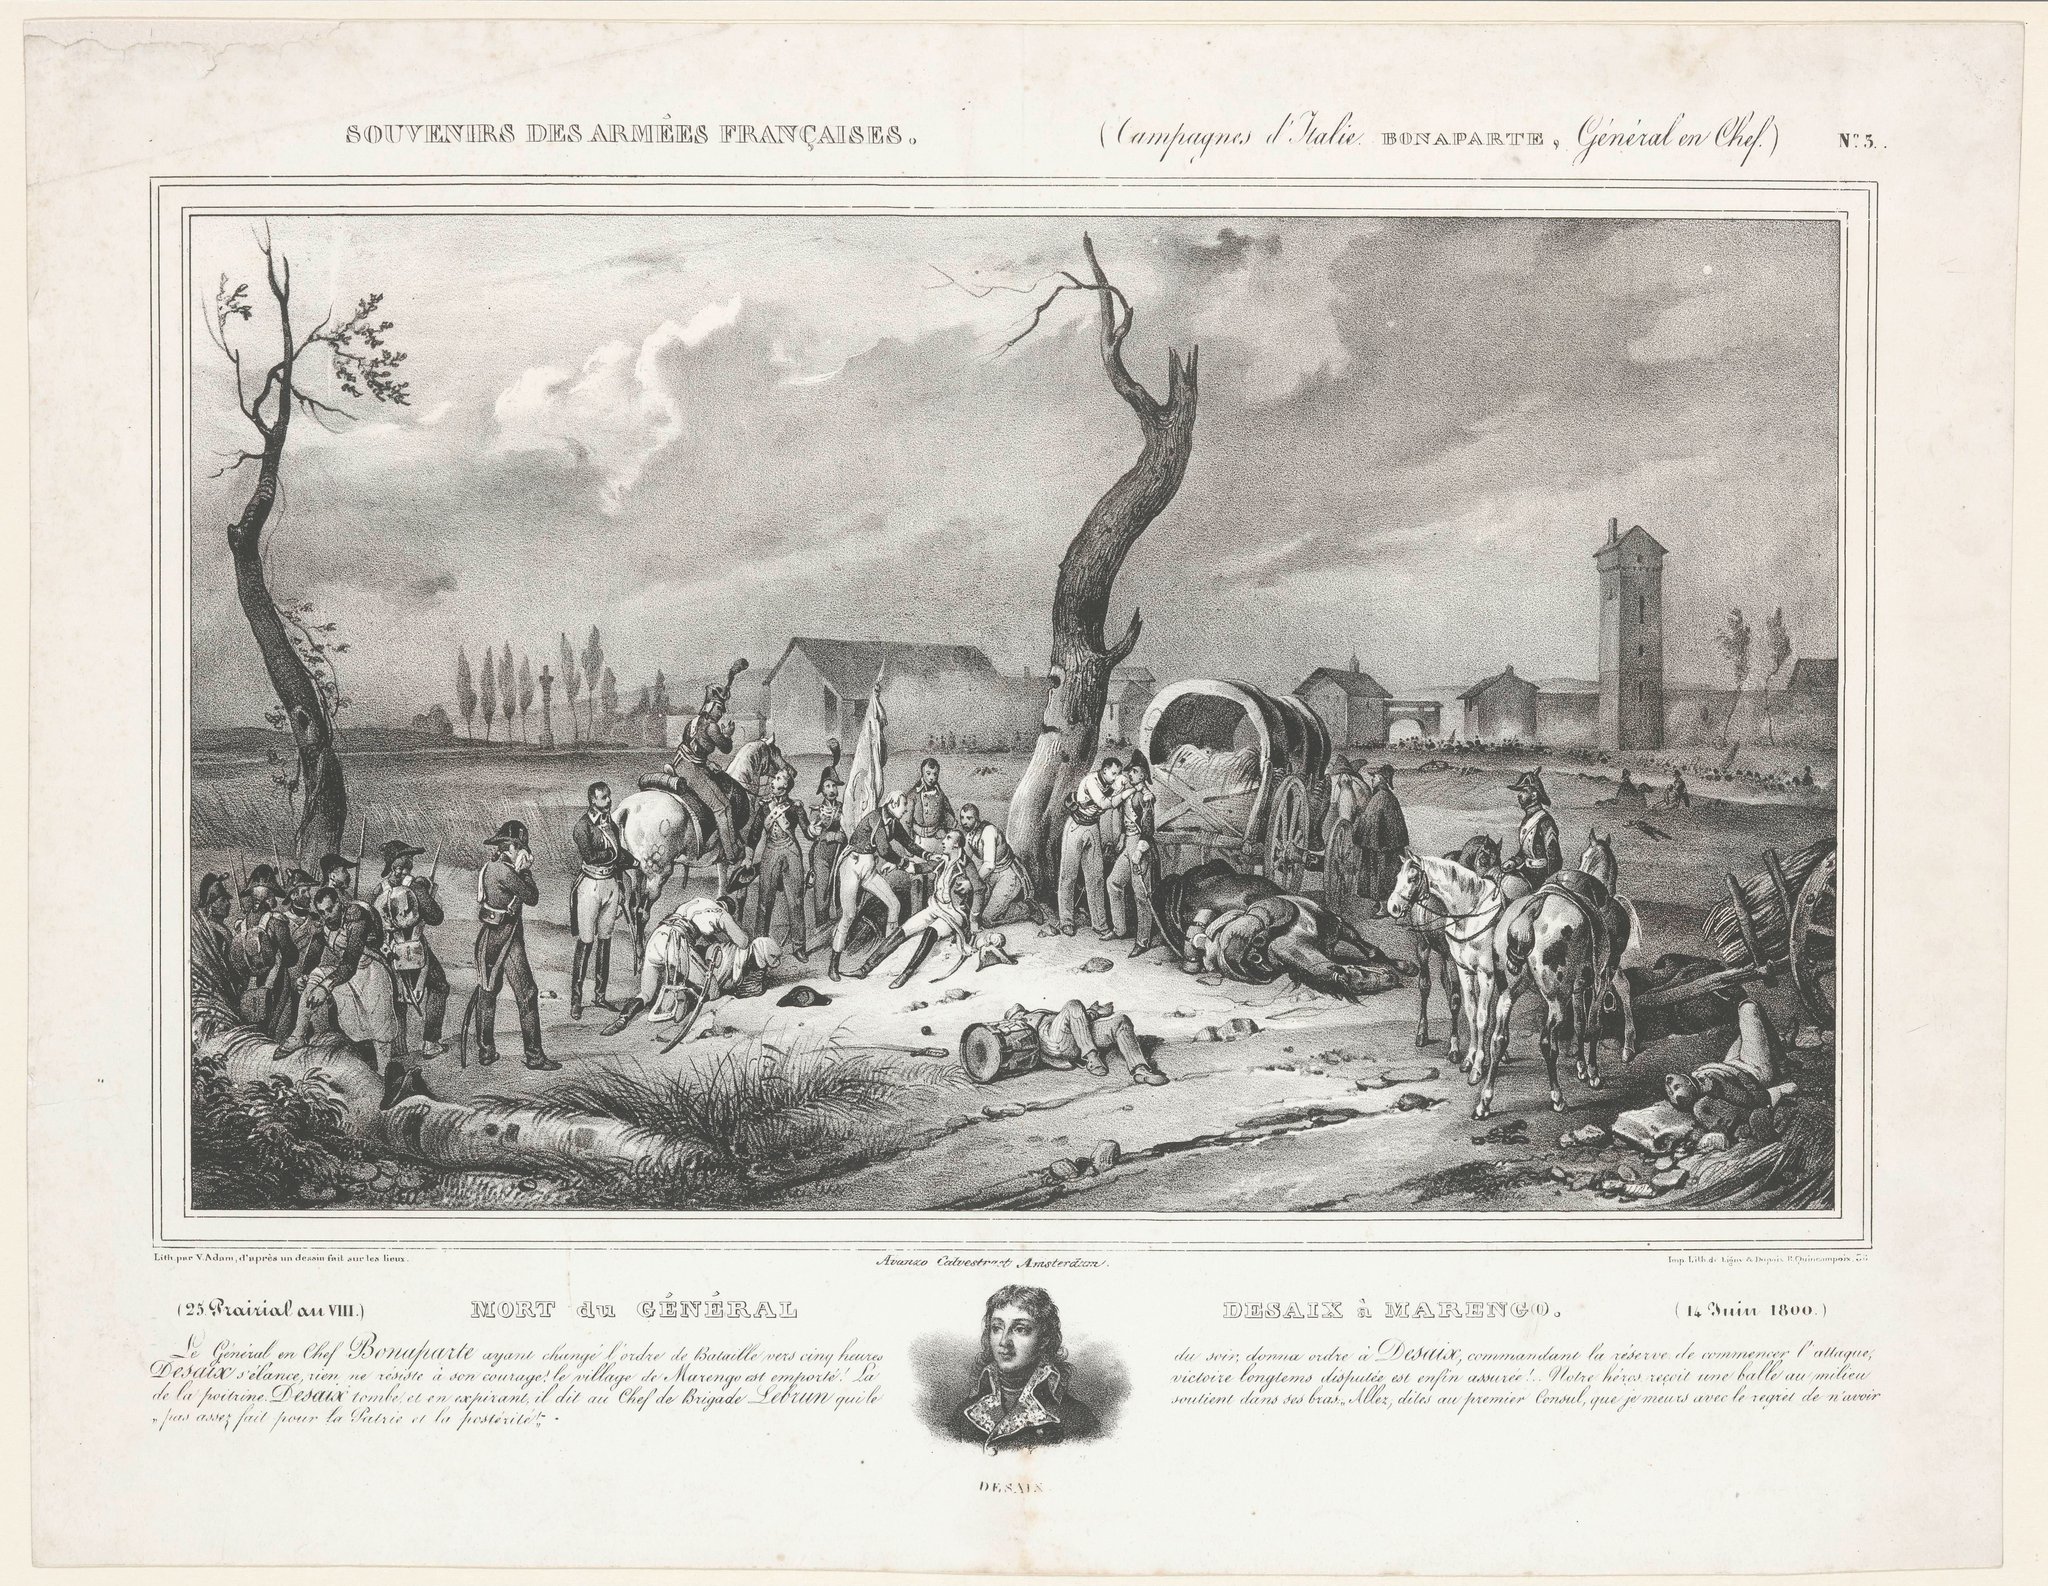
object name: print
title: Souvenirs des Armées Françaises (Campagnes d'Italie, Bonaparte, Général en Chef)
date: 1829-1830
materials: paper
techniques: lithograph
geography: paris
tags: commander-in-chief, general, marshal, dying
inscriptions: collector's mark: Lugt 2228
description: Dood van generaal Louis-Charles-Antoine Desaixtijdens de slag bij Marengo op 14 juni 1800. Onder de voorstelling een portretje van Desaix tussen tekst. No. 5 in een serie platen over de Italiaanse veldtochten van Napoleon 1796-1800.